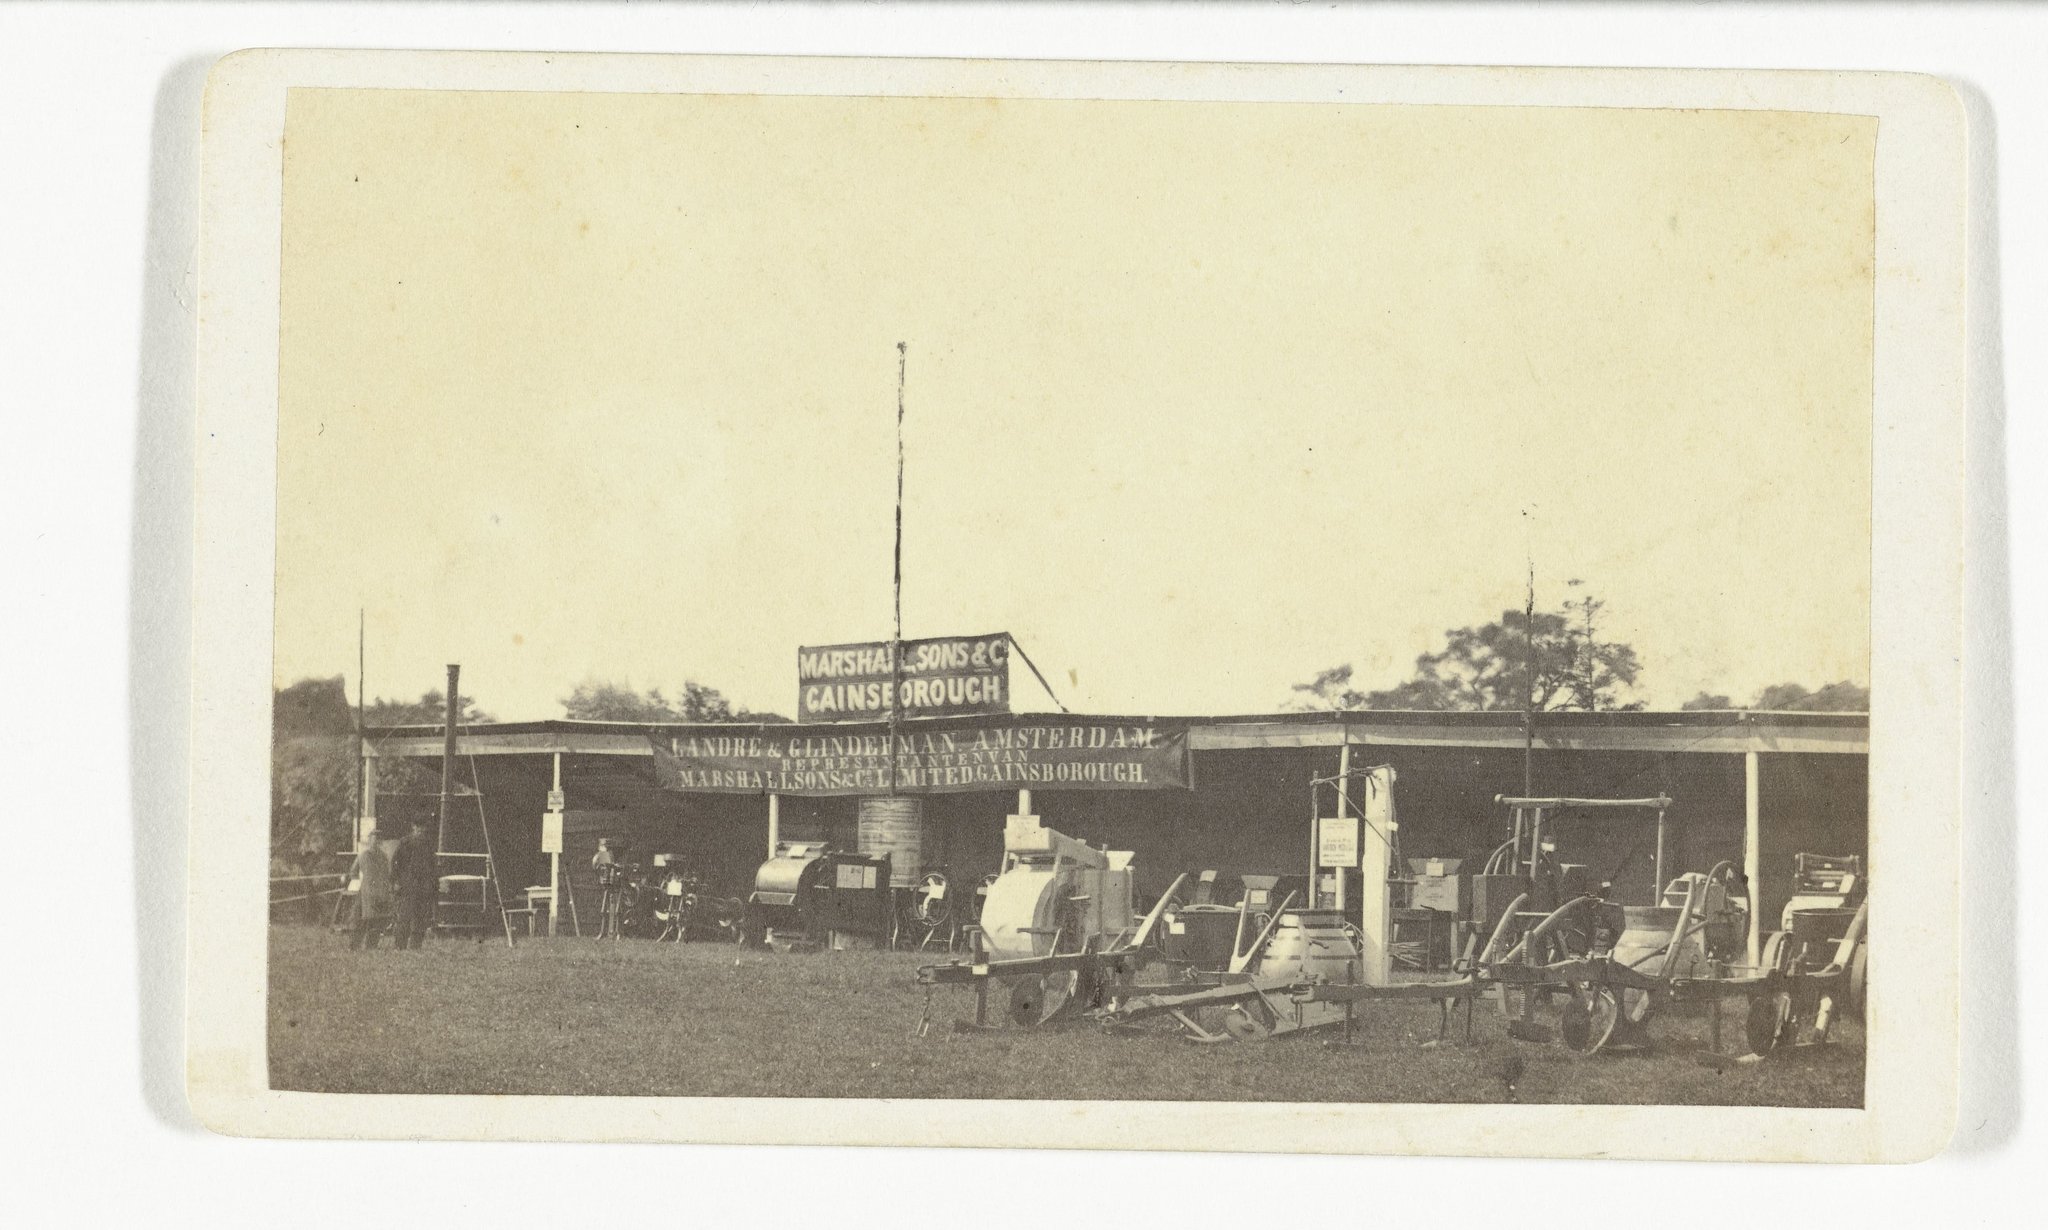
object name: photograph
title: Gezicht op een landbouwtentoonstelling in Middelburg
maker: jan wendel gerstenhauer zimmerman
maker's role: draughtsman, print maker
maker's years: 1816-1887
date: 1862-1870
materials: cardboard, photographic support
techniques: albumen print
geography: middelburg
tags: collection, exhibition, show, agriculture, middelburg